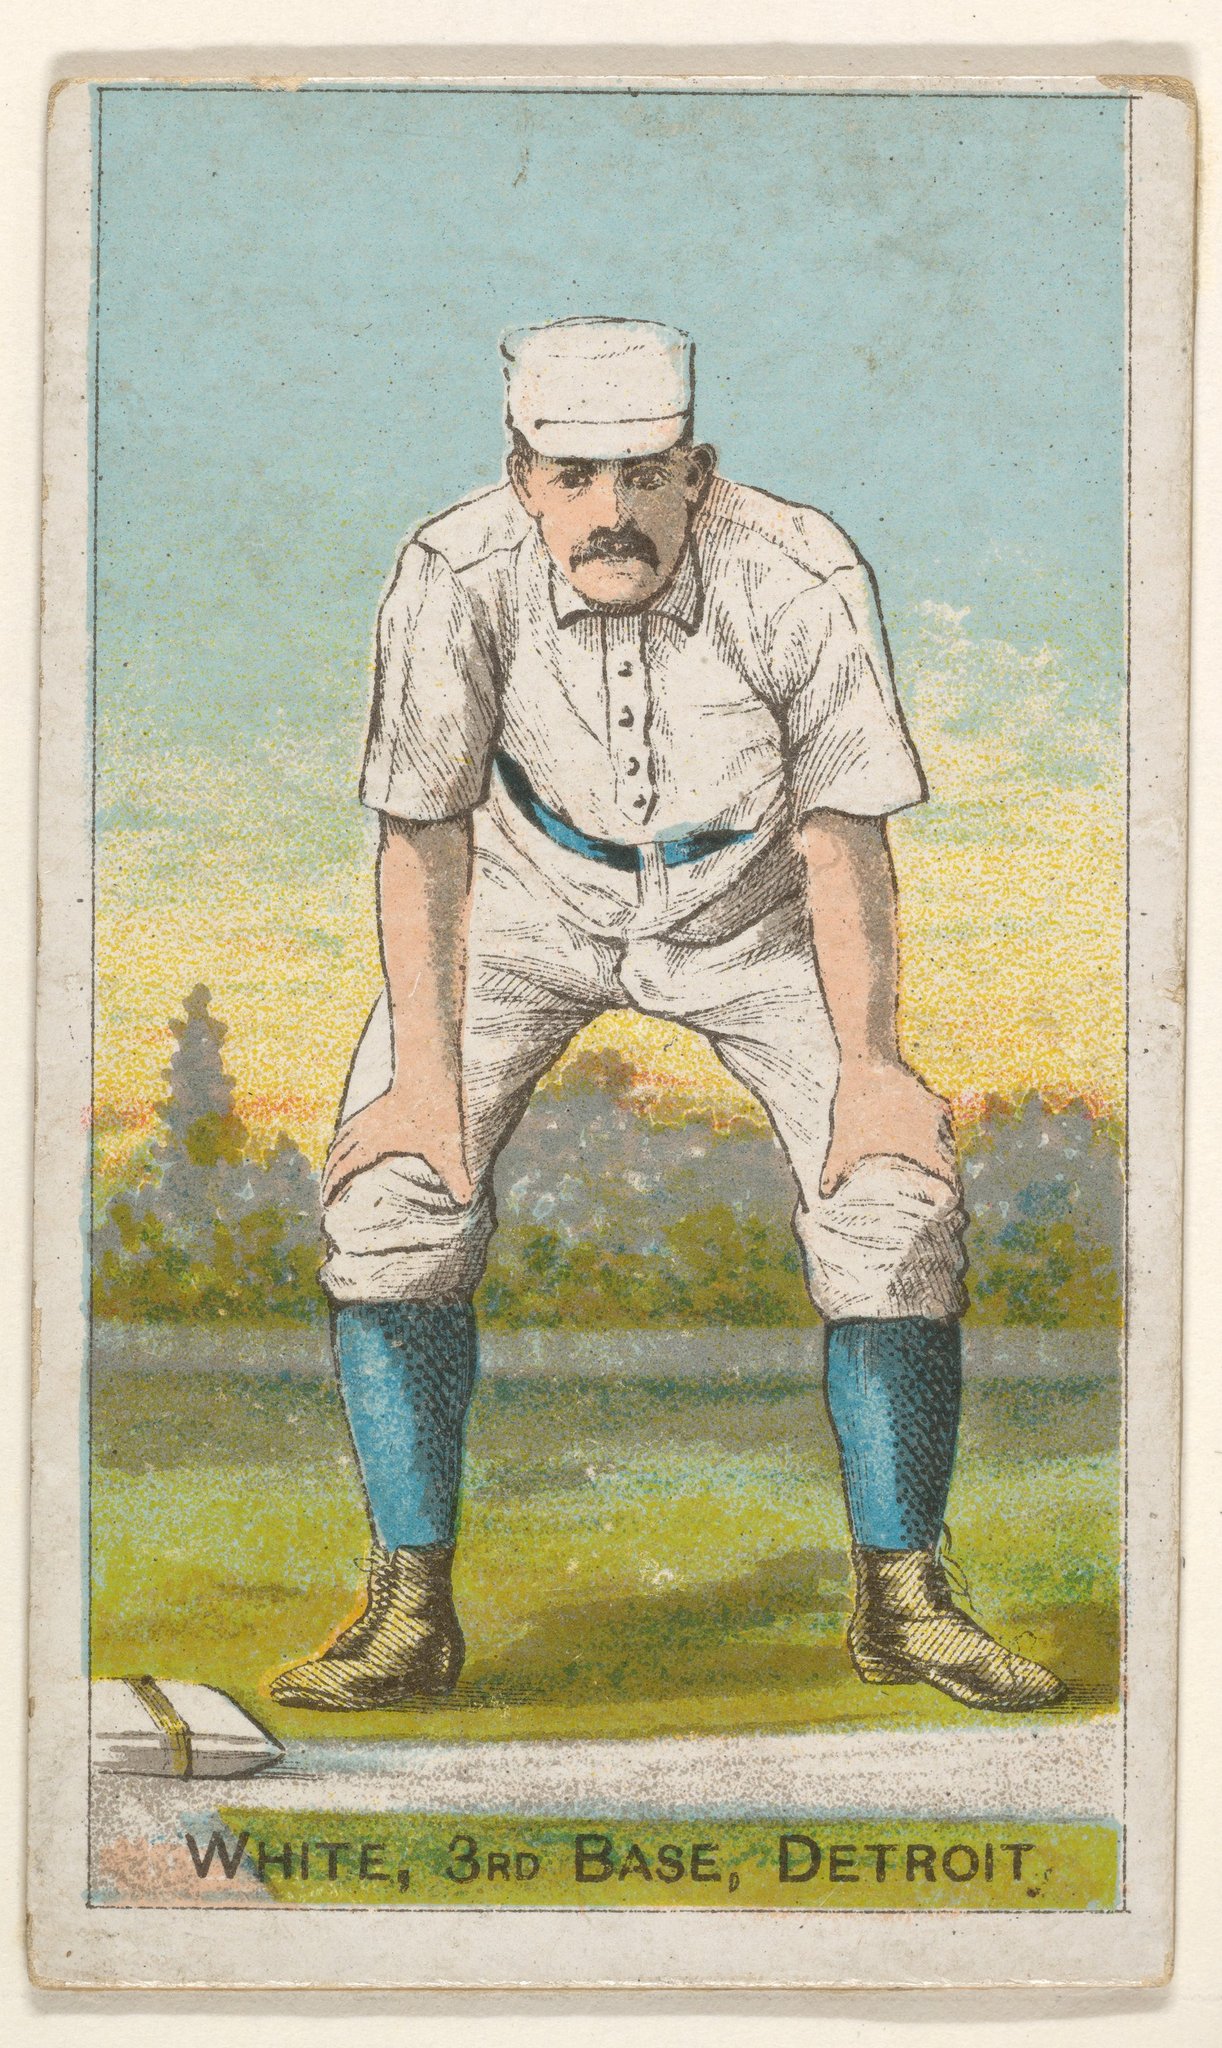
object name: baseball card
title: White, 3rd Base, Detroit, from the Gold Coin series (N284) for Gold Coin Chewing Tobacco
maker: d. buchner & co., new york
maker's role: publisher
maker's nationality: american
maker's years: 1850-1900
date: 1887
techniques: color lithograph, drawing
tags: men,baseball,athletes